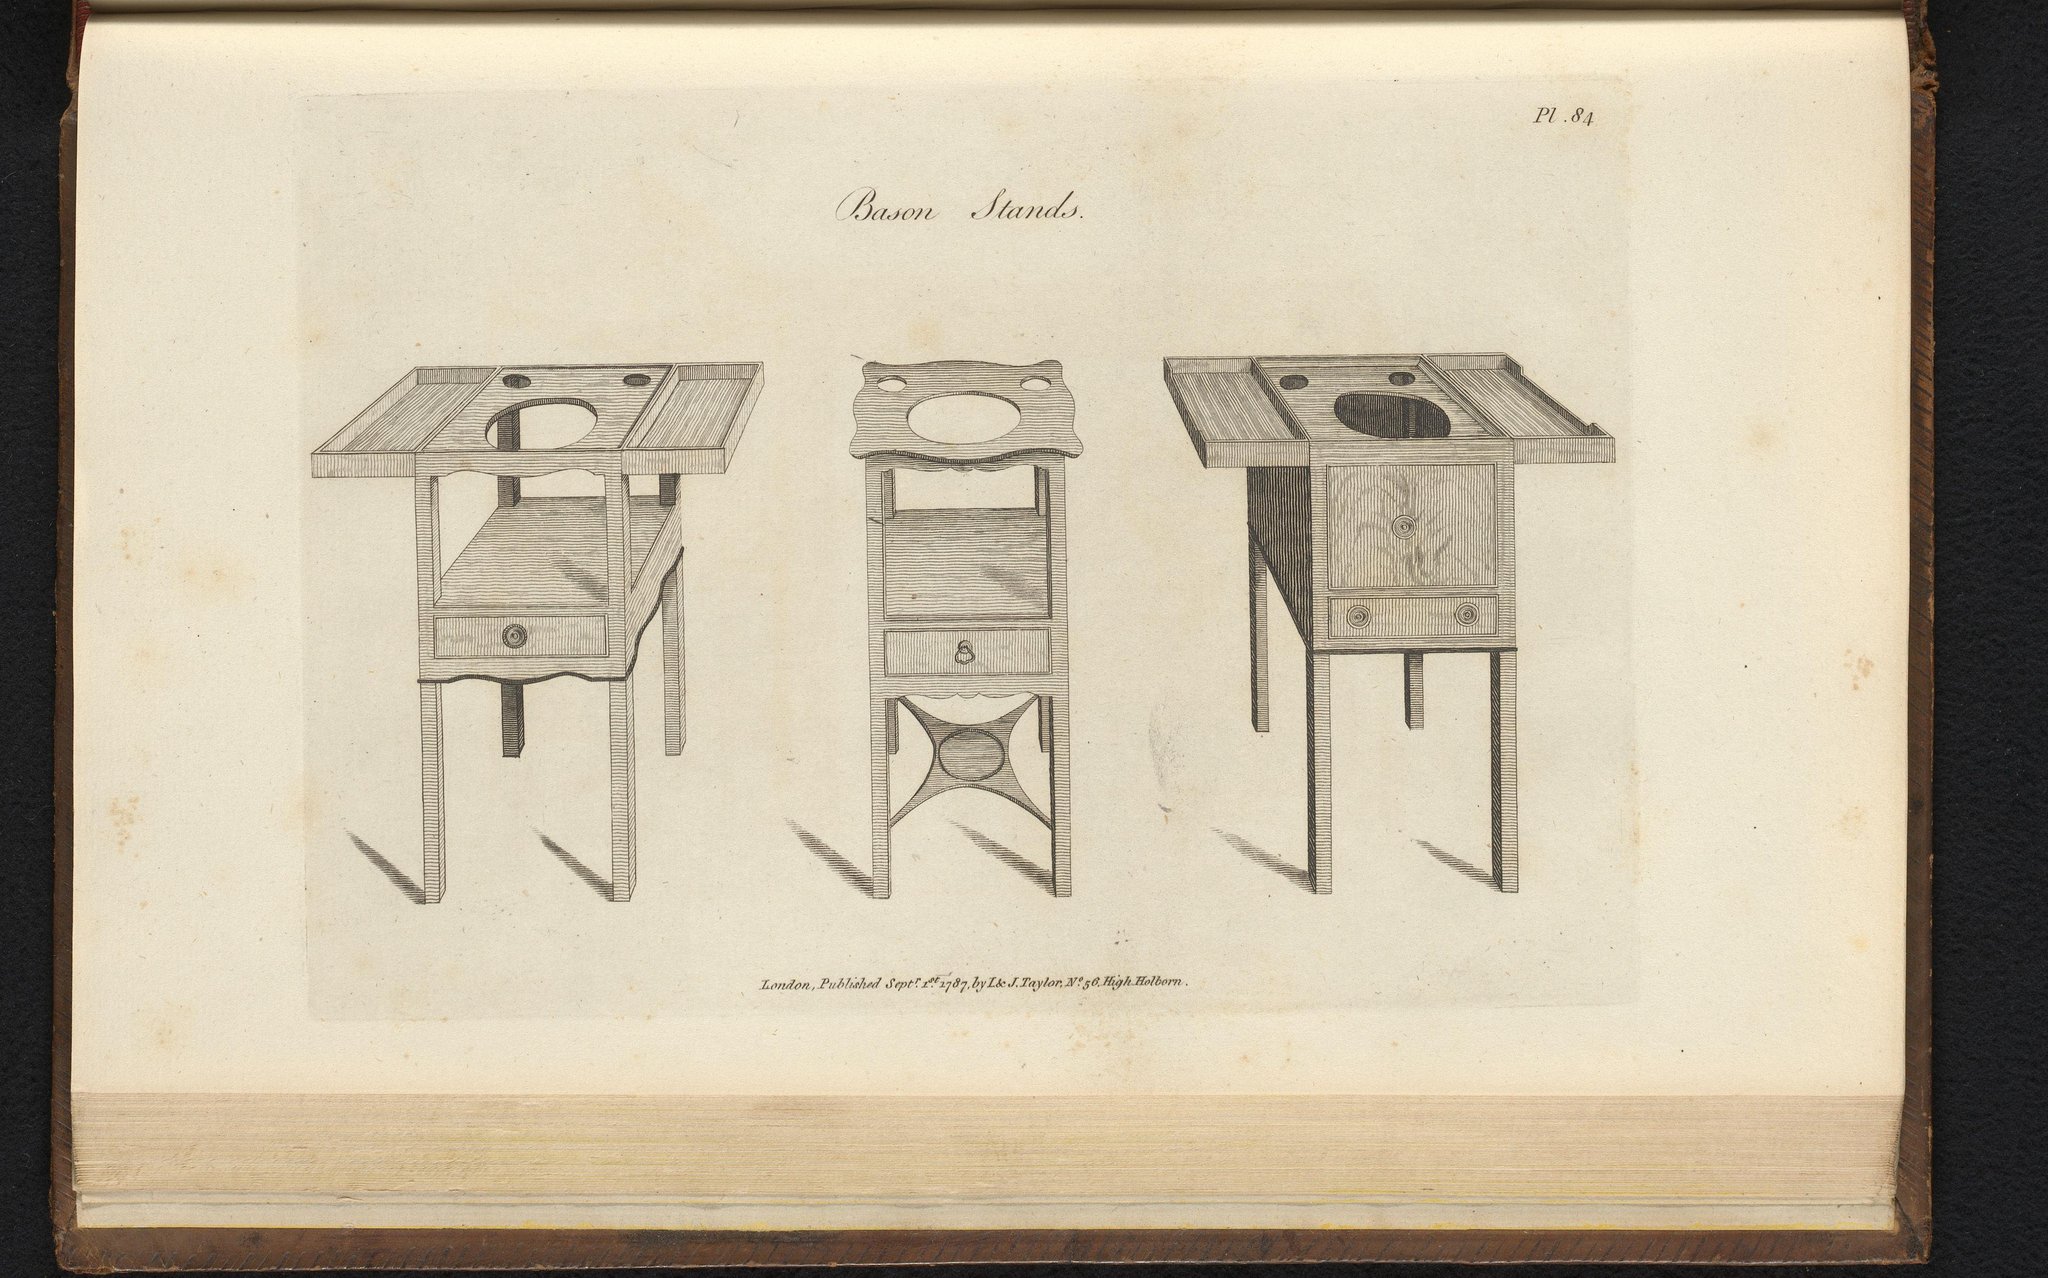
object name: page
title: Bason Stands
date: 1787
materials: paper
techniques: engraving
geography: holborn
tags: aquamanile, vessel holding water for washing the hands before a meal, furniture and household effects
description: Genummerd: Pl. 84. Prent maakt deel uit van een boek.